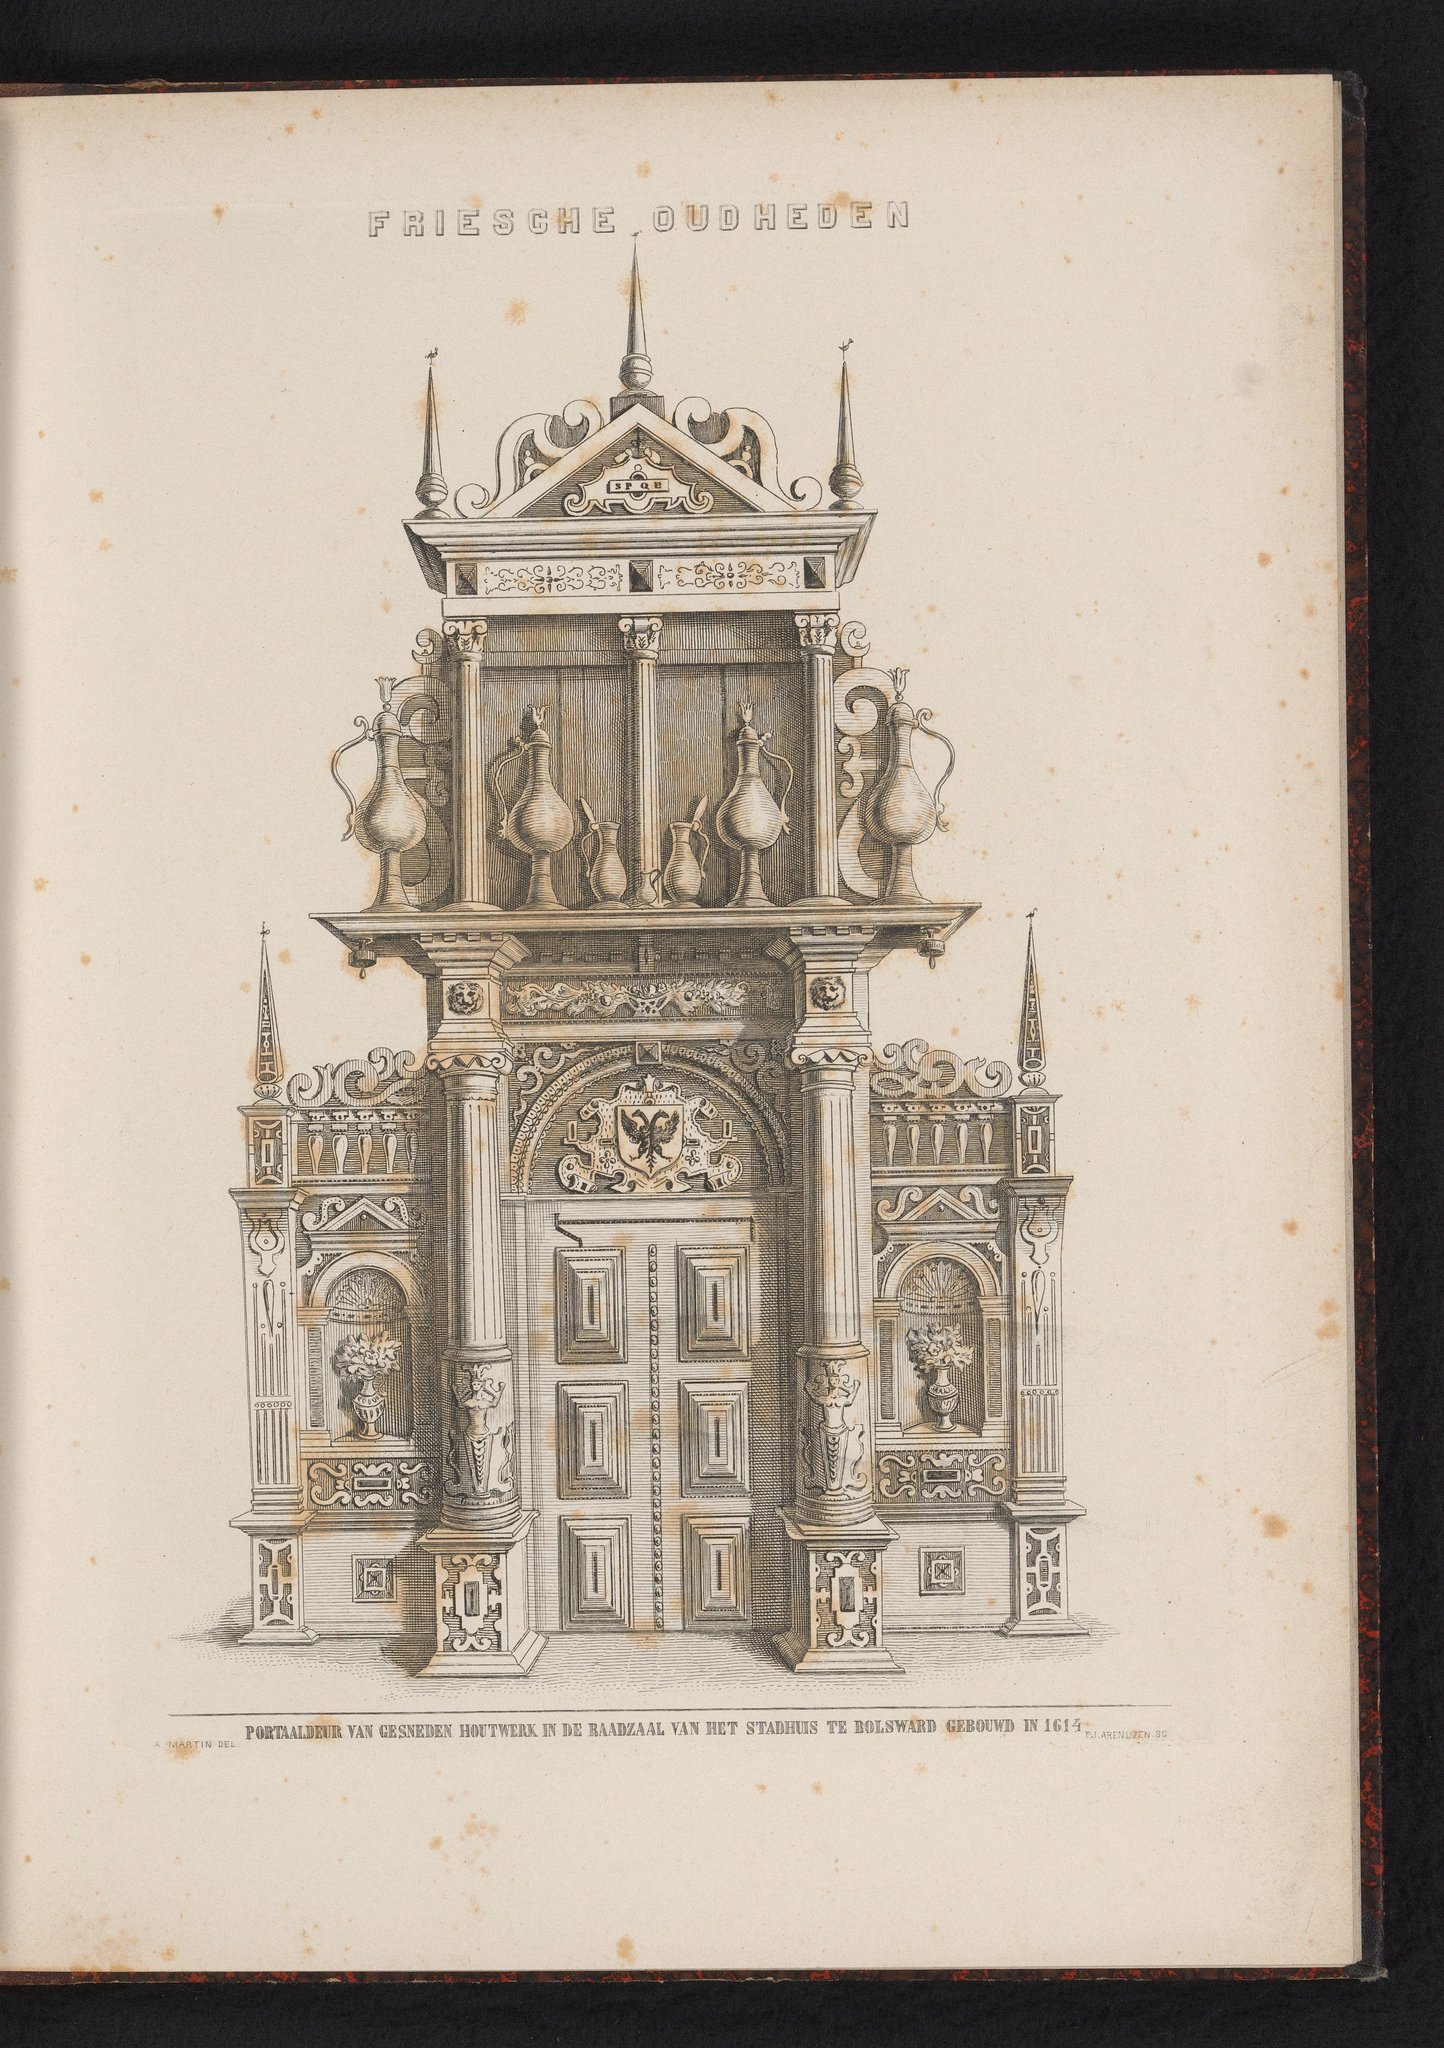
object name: print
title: Het raadhuis te Bolsward uit 1614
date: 1870-1875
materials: paper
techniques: etching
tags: piece of sculpture, reproduction of a piece of sculpture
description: Illustratie in: Friesche Oudheden. Afbeeldingen van merkwaardige voorwerpen van Wetenschap en Kunst, gevonden in de archieven, kerken, kasteelen, terpen enz. van Friesland, Leeuwarden 1875. Niet in Frederik Muller; door het RPK toegevoegd nummer.